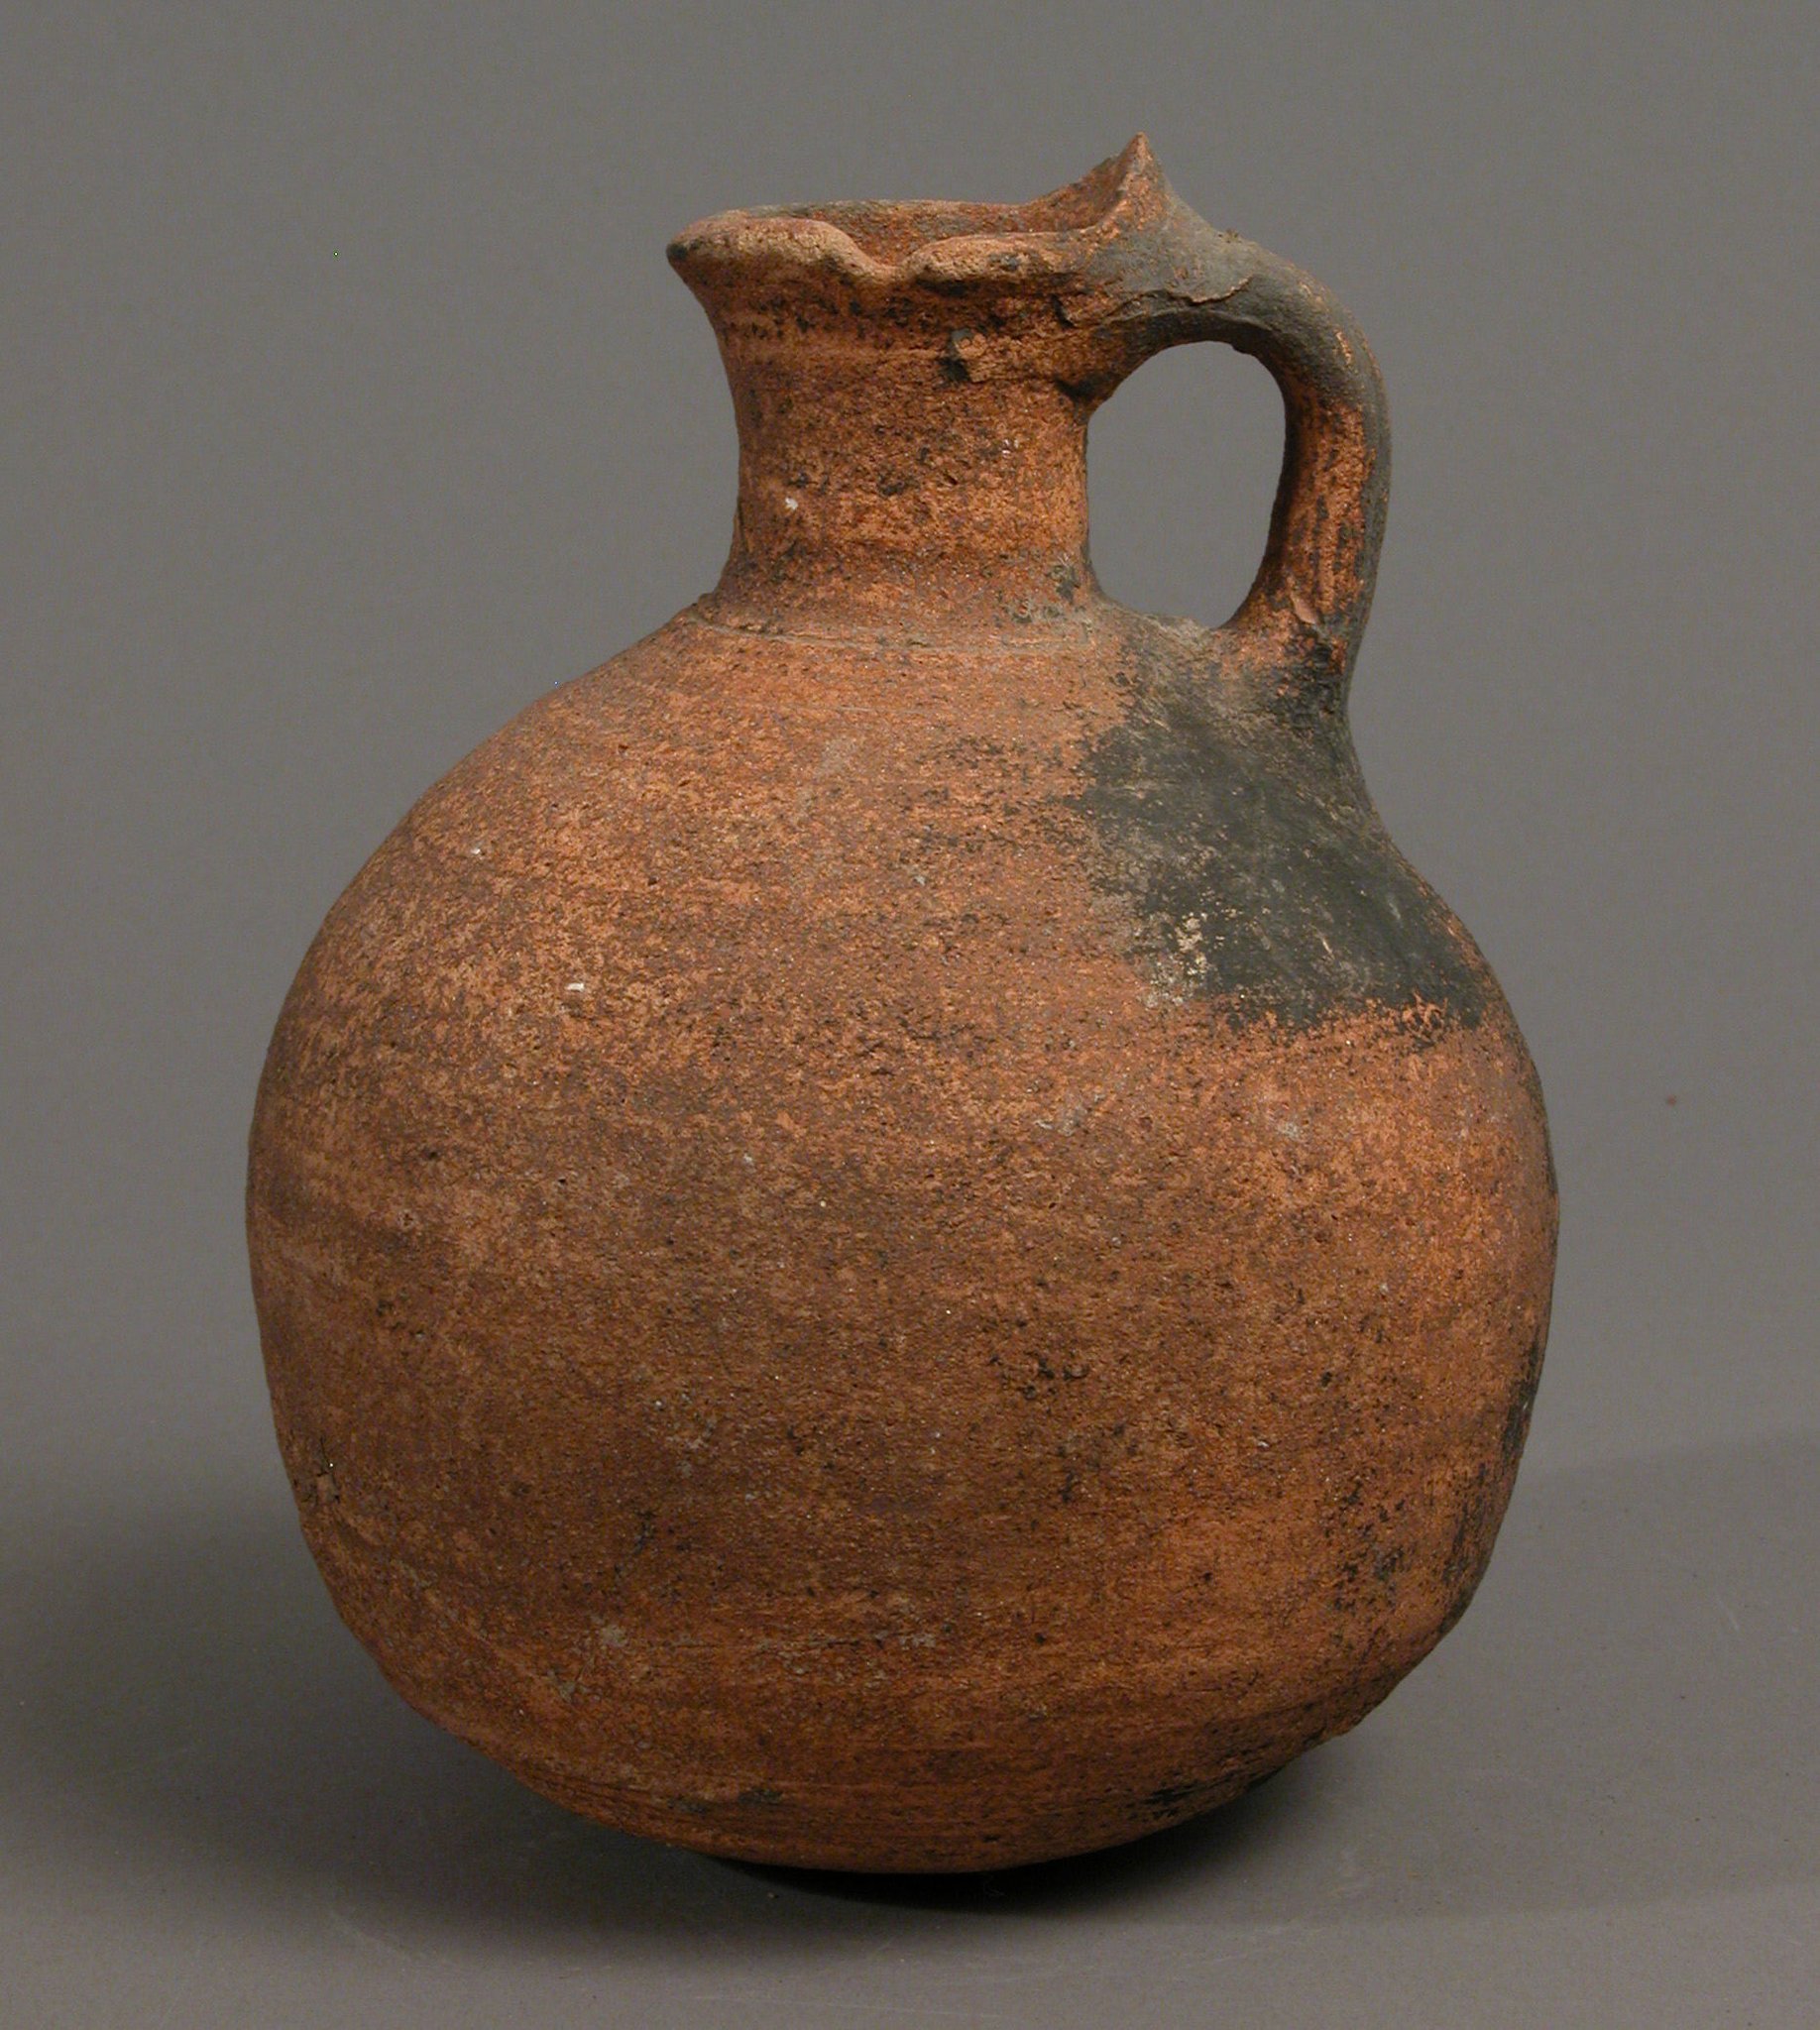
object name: jug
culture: coptic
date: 301-700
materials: earthenware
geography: egypt